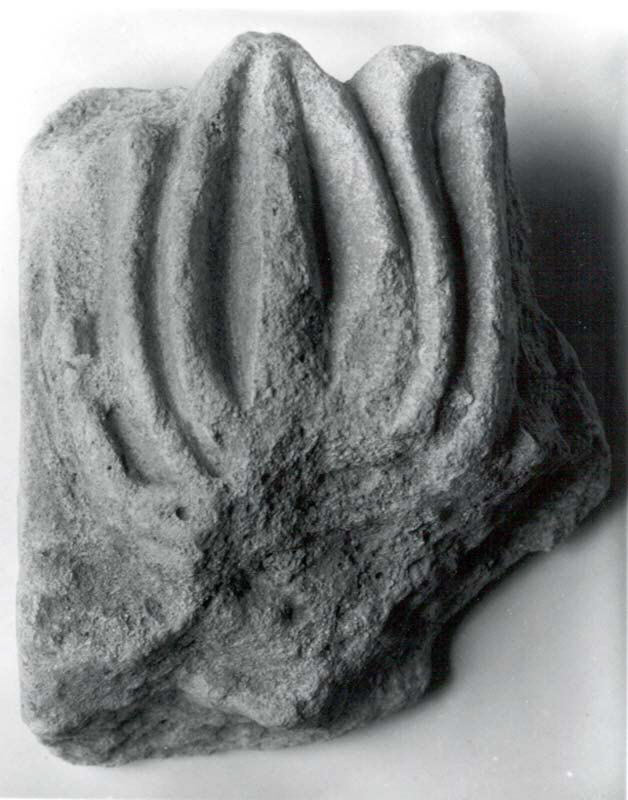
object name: relief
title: Relief fragment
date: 501-700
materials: plaster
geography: mesopotamia